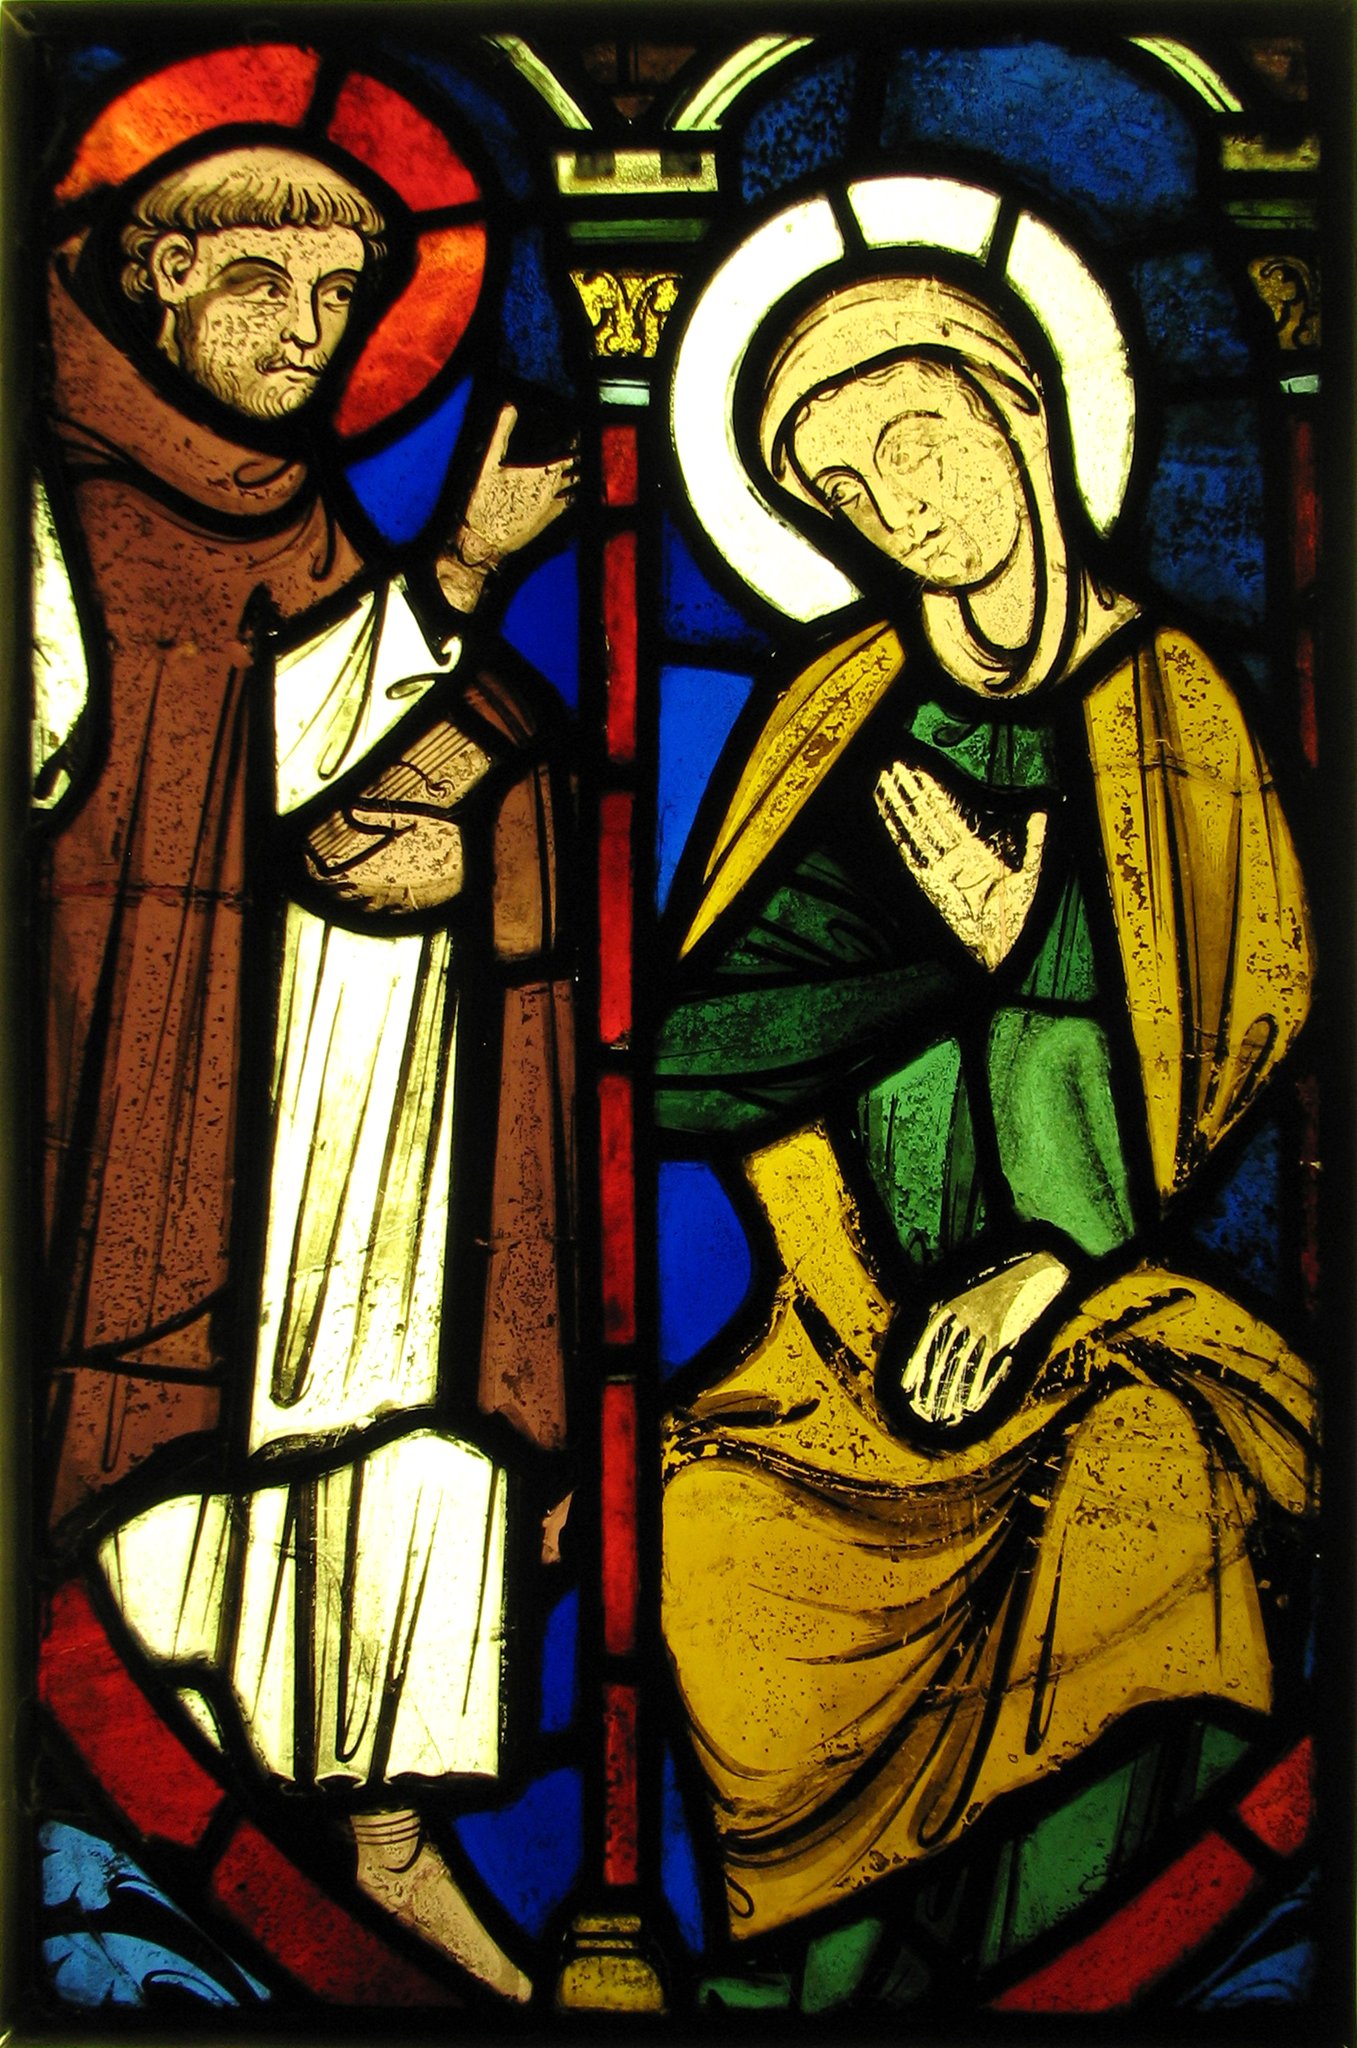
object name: panel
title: The Virgin from a Pentecost Scene and the Figure of Saint Martin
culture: french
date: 1245-1248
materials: glass, metal, paint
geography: france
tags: men,virgin mary,saints